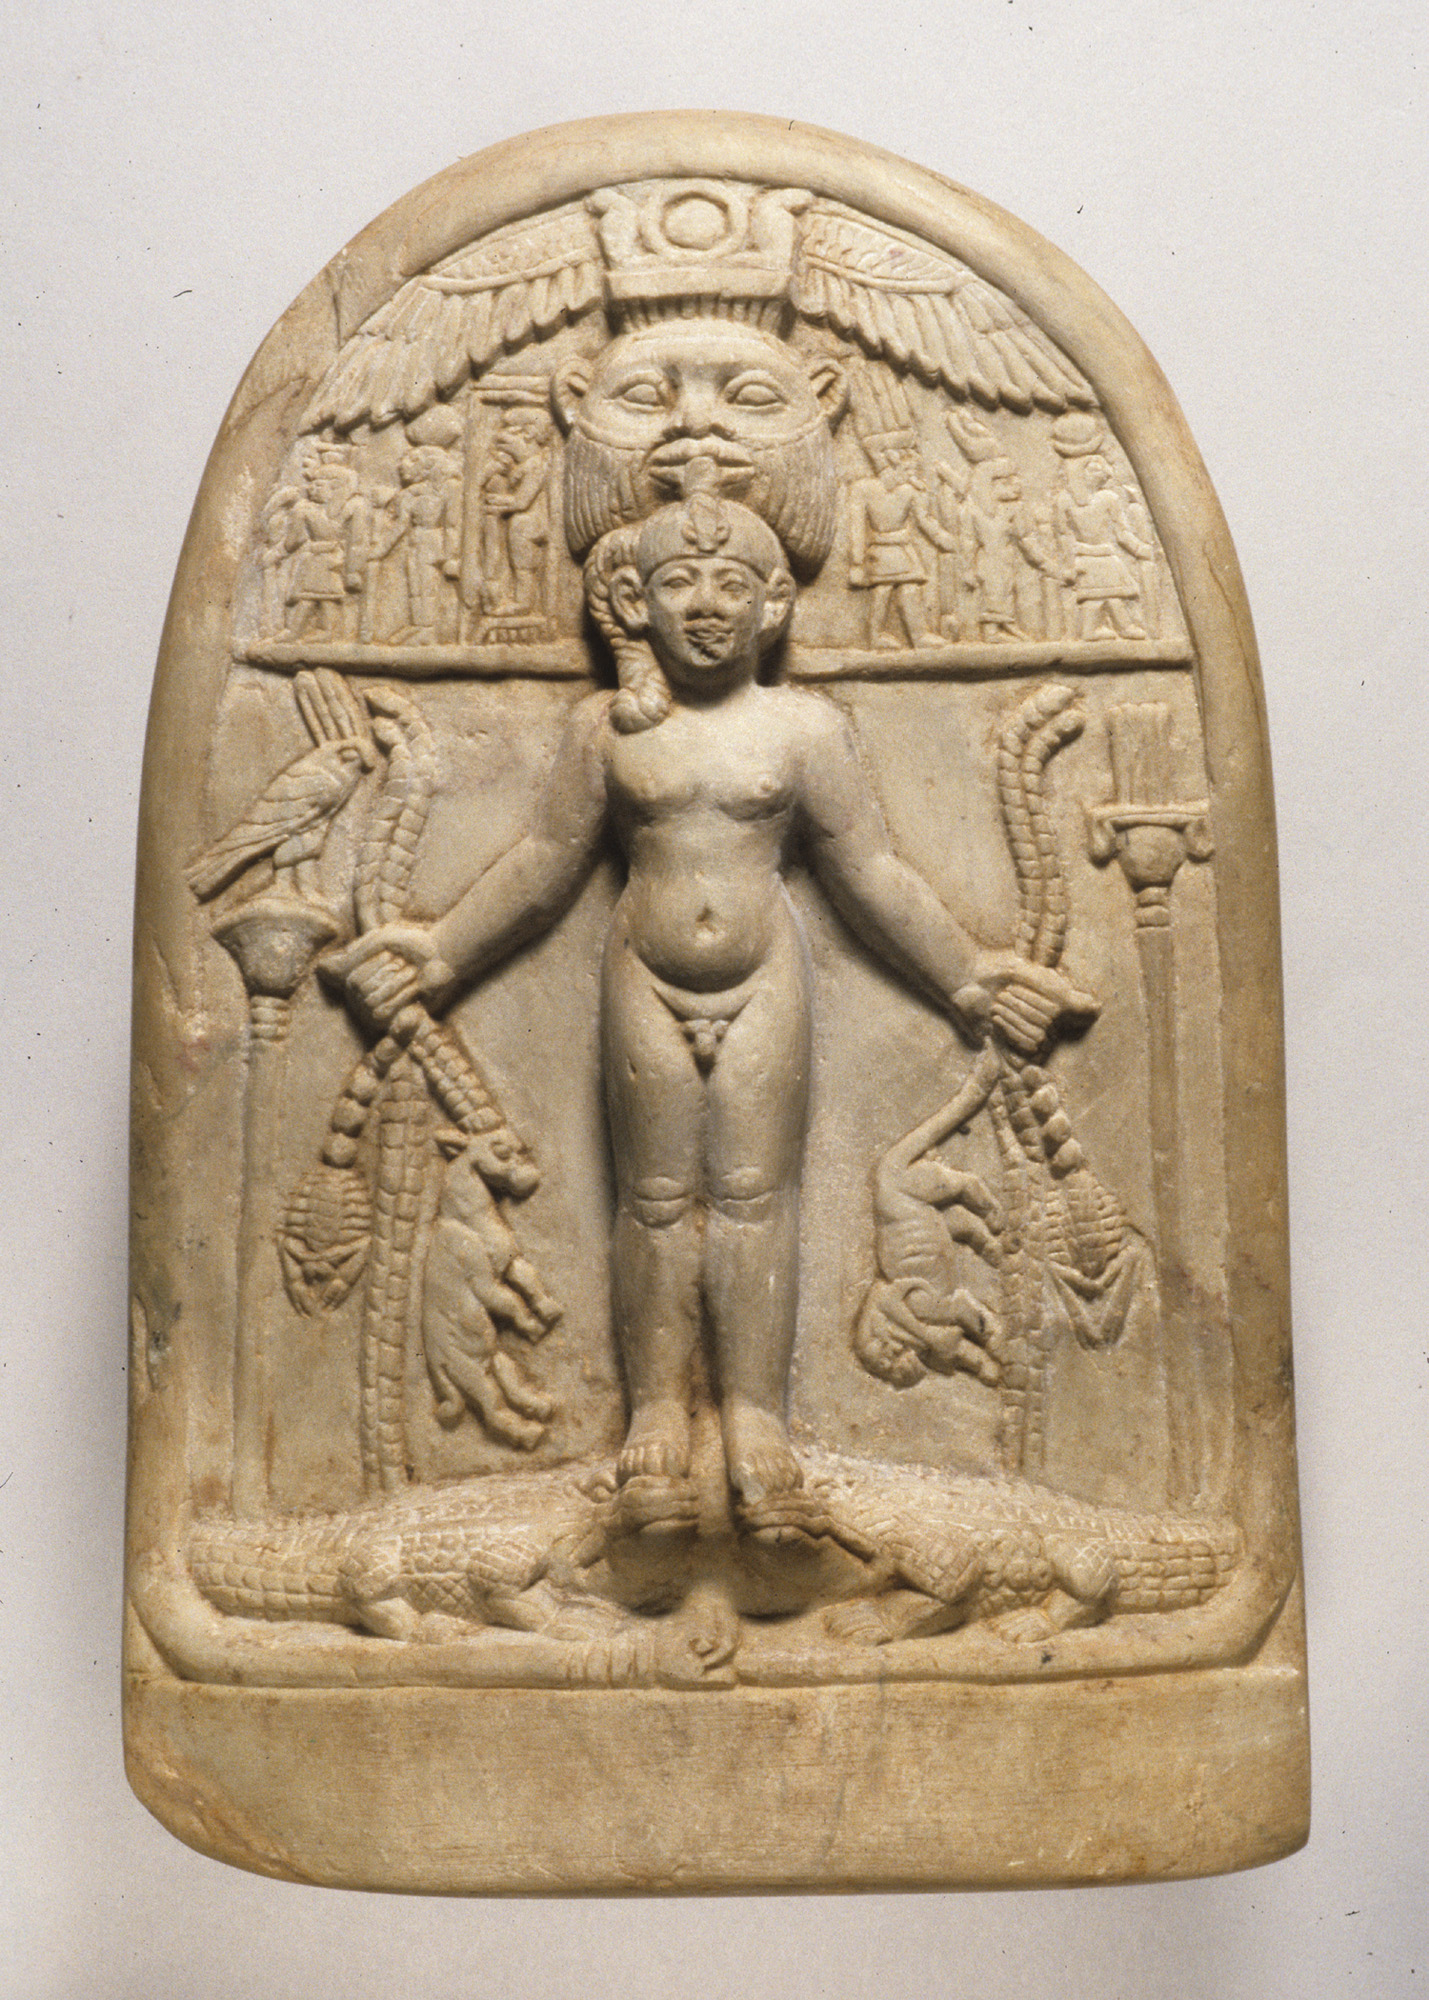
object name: cippus, horus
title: Cippus of Horus (magical stela)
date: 664-630 BCE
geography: egypt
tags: birds,horus,crocodiles,scorpions,lions